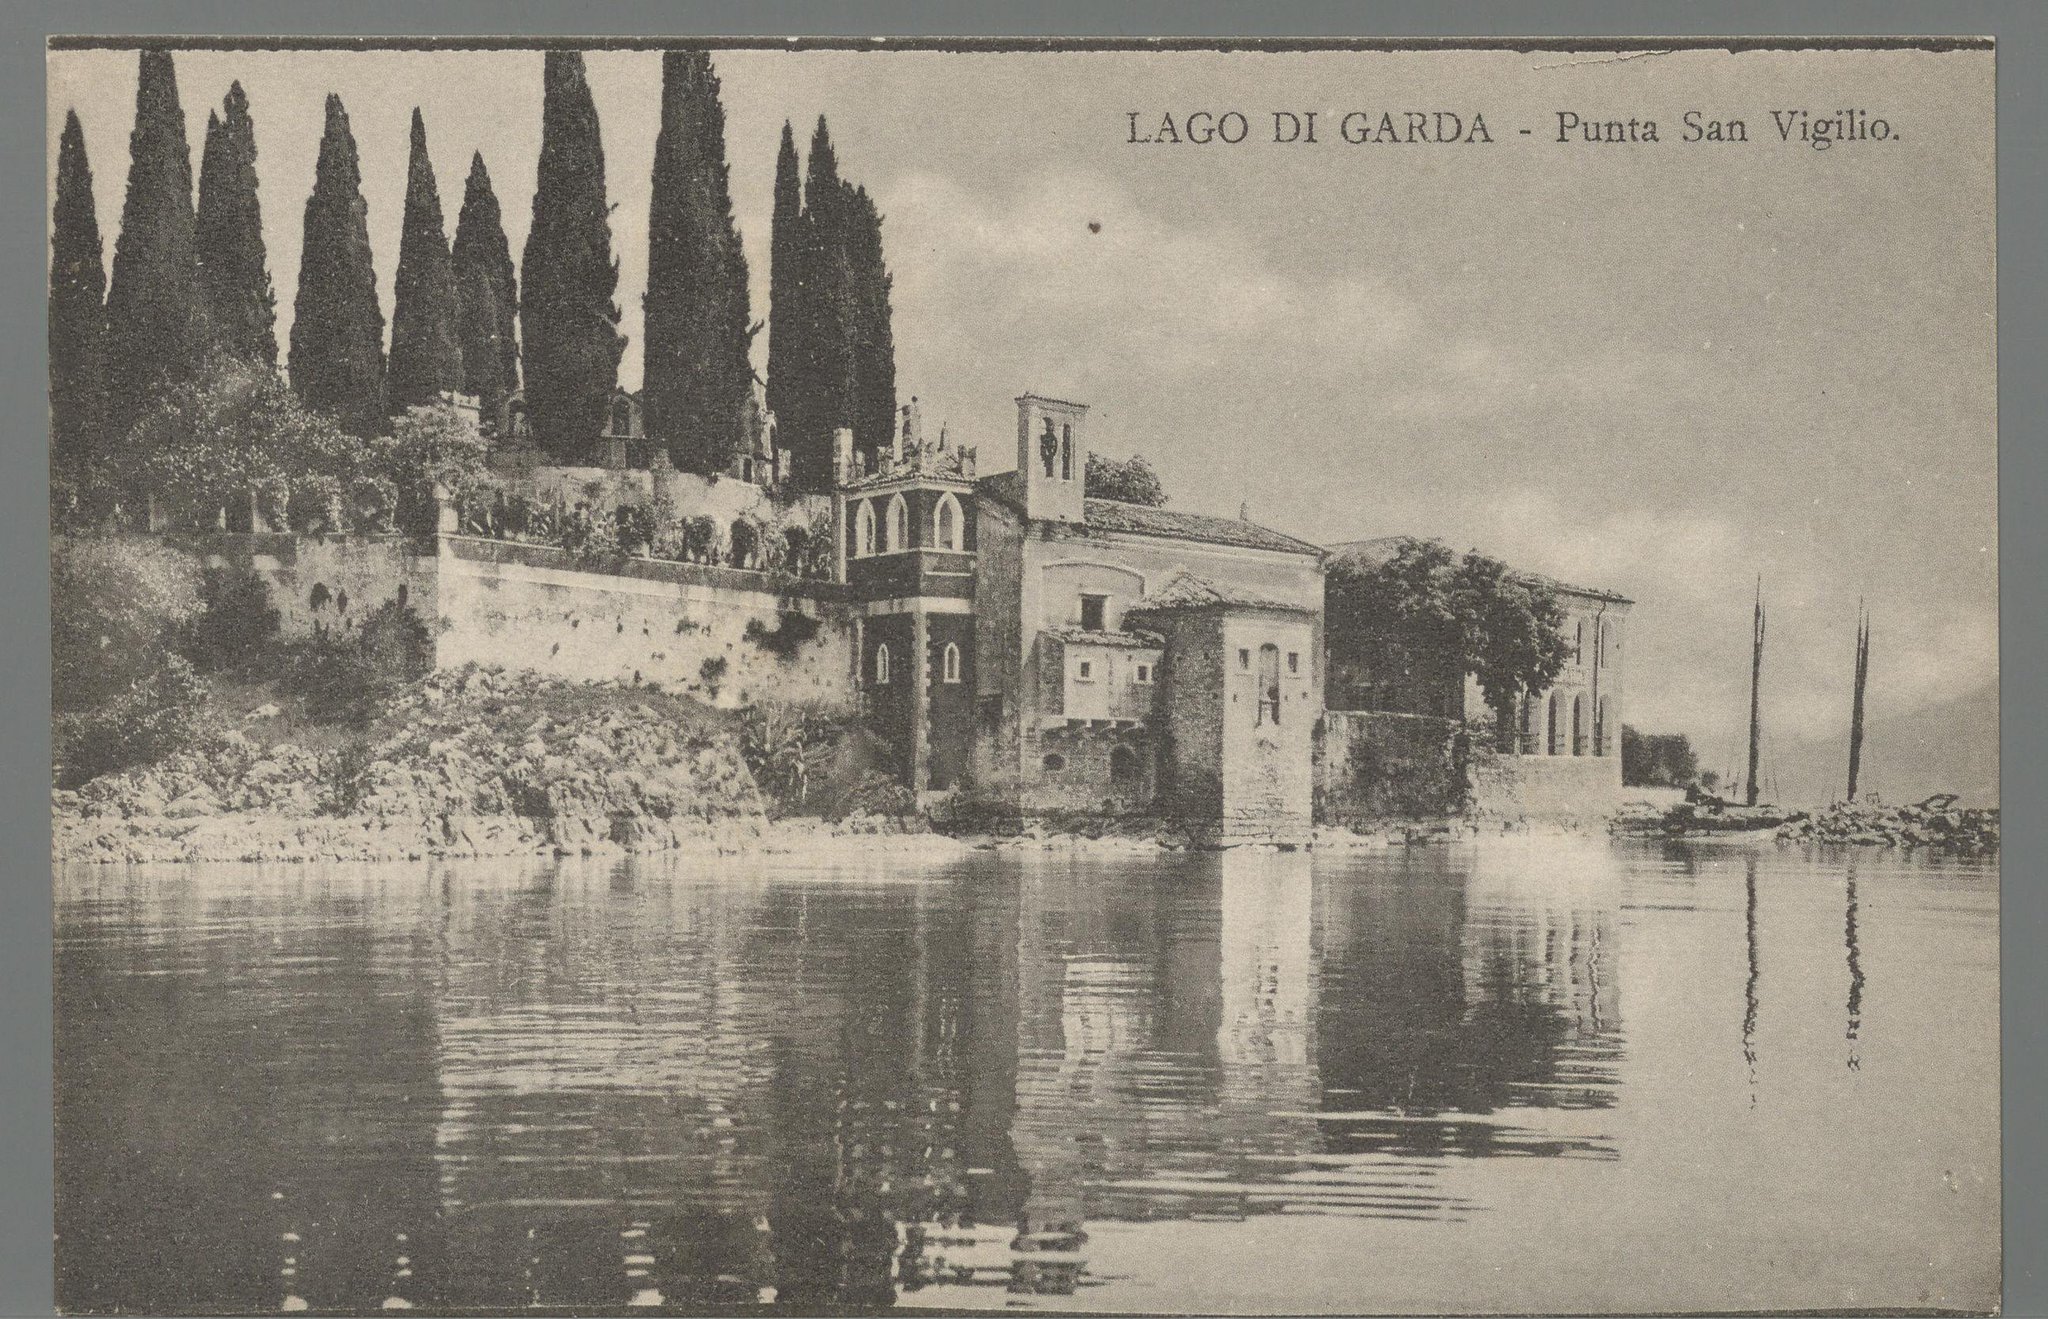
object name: ansichtkaart, prentbriefkaart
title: Lago di Garda. Punta San Vigilio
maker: Anonymous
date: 1906-1930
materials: cardboard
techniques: photograph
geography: lake garda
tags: prospect of village, silhouette of village, lake